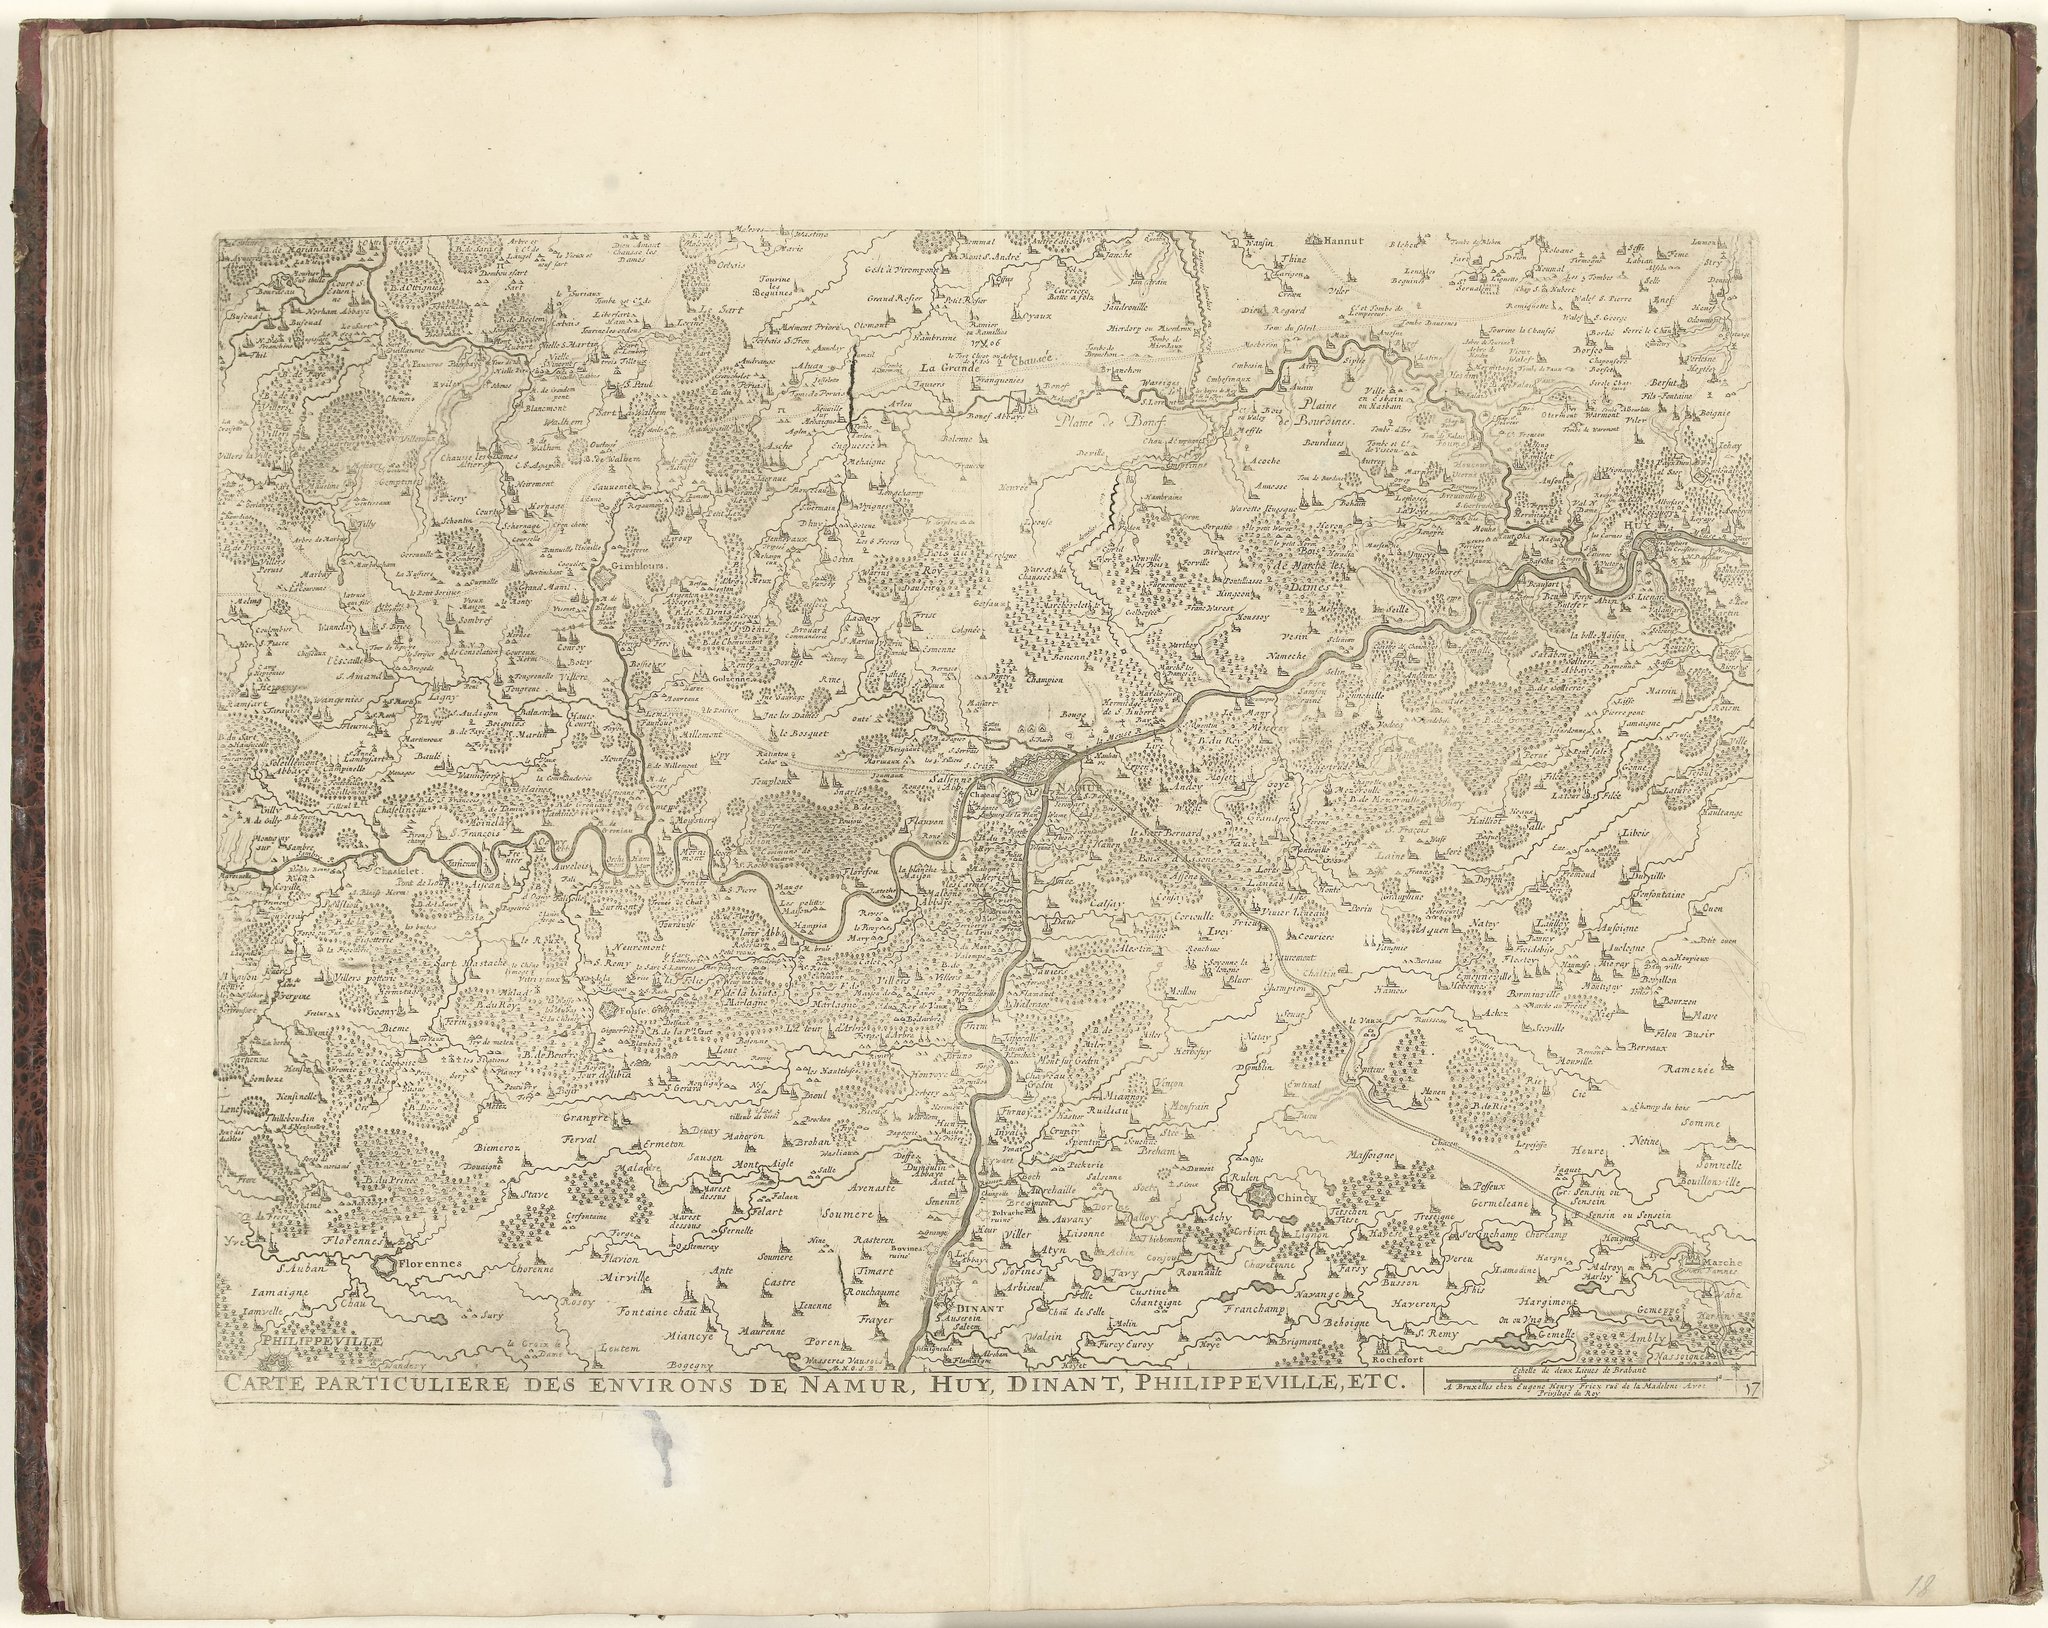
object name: print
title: Kaart van de provincie Namen, ca. 1706-1712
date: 1706-1712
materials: paper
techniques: engraving, etching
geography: brussels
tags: maps of separate countries or regions, namur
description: Kaart van de provincie Namen met de steden Namen, Huy, Dinant en Philippeville, ca. 1706-1712. Onderdeel van een gebundelde verzameling van plannen van veldslagen en steden vermaard in de Spaanse Successieoorlog. Deze plaat behoort tot de eerste 24 platen die samen een zeer grote kaart van de Zuidelijke Nederlanden vormen.